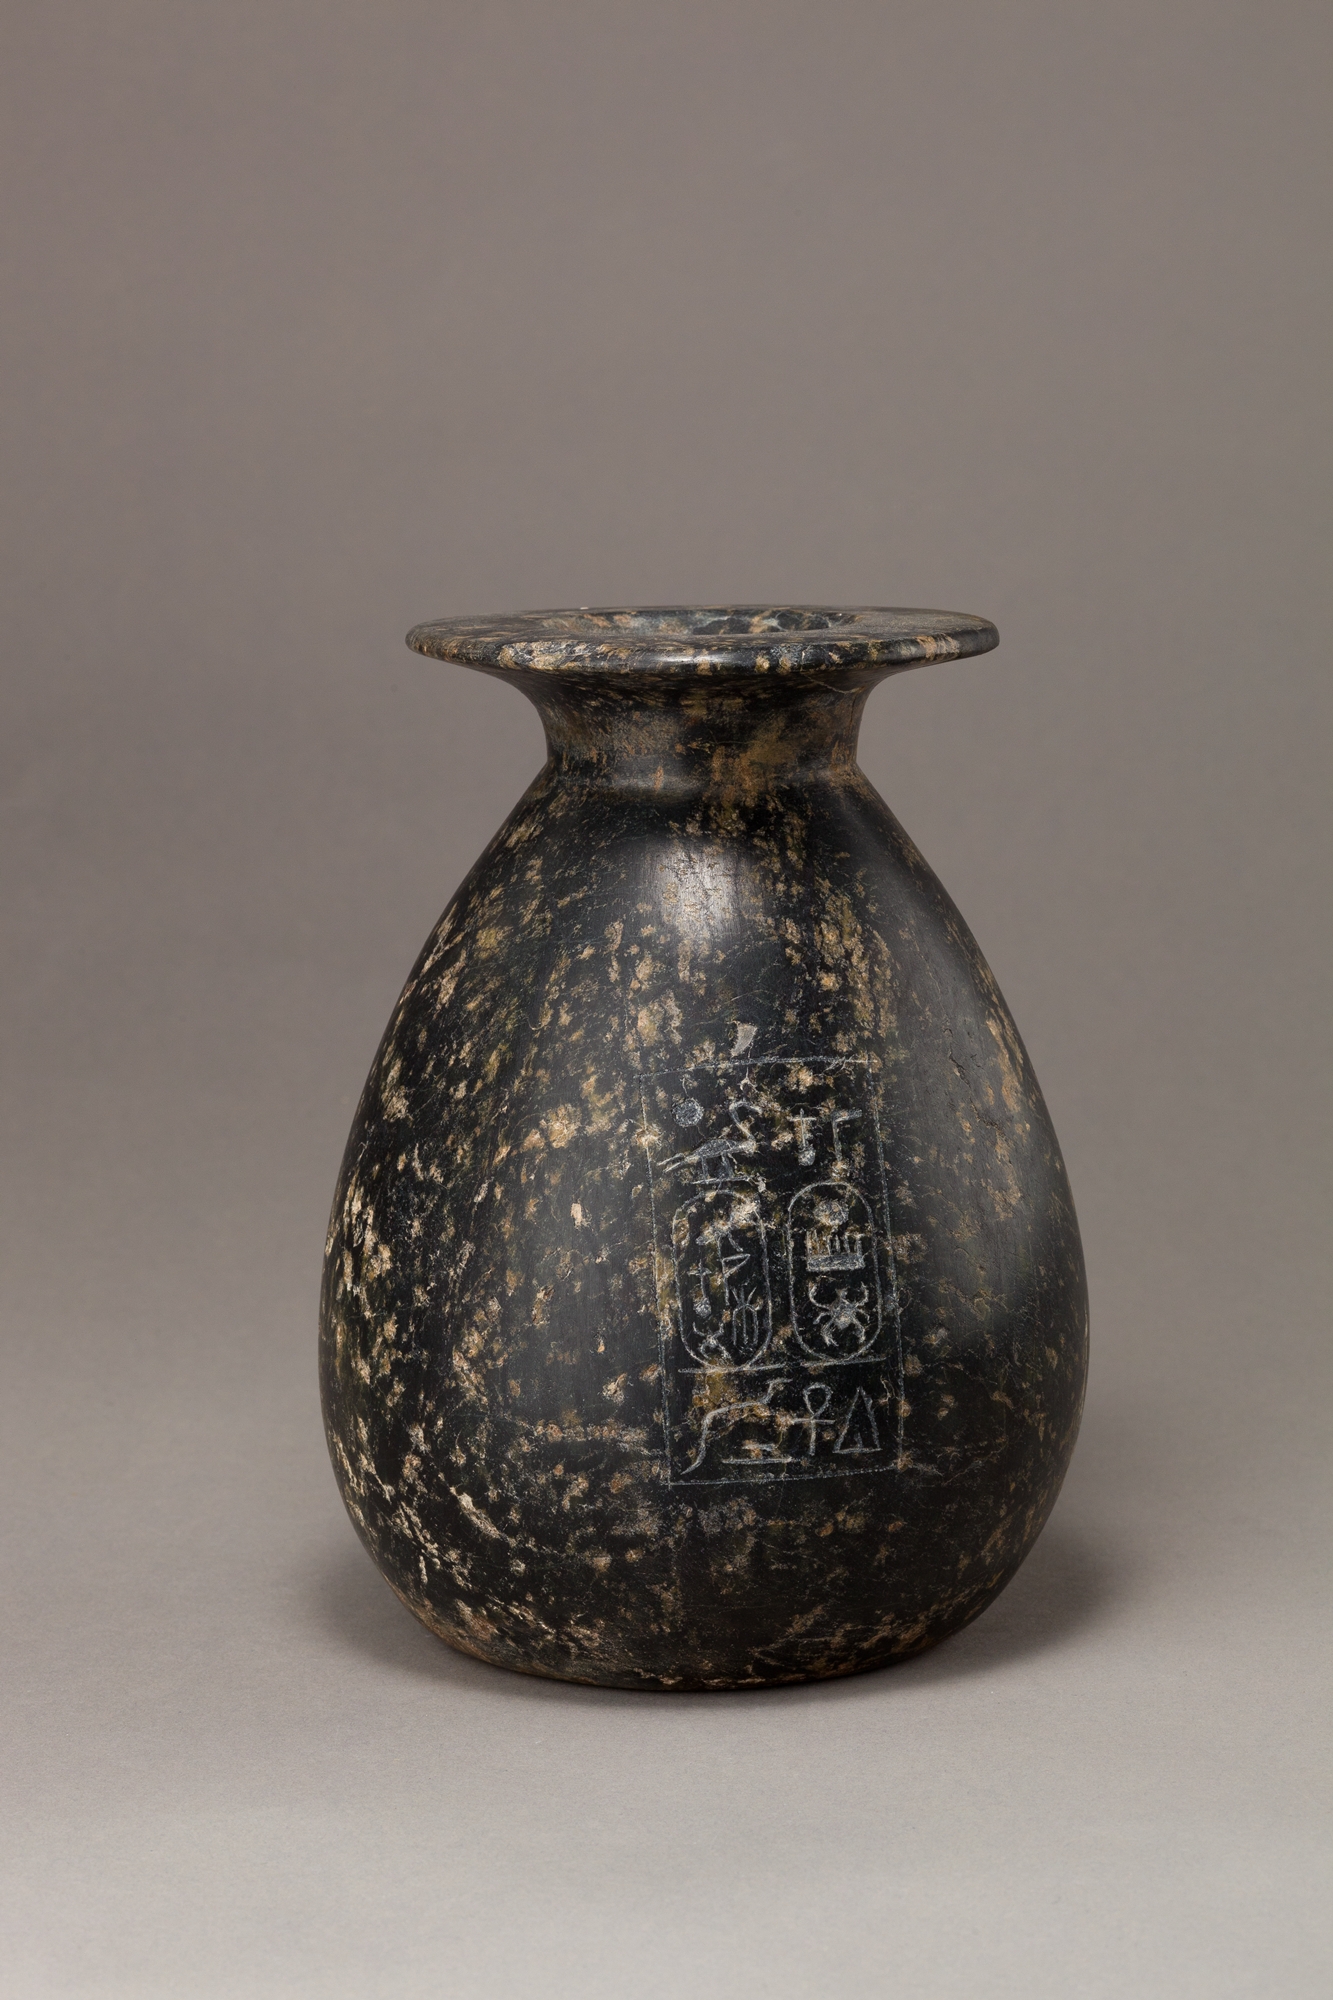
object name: jar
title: Piriform storage jar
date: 1479-1425 BCE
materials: stone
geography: egypt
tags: cartouches